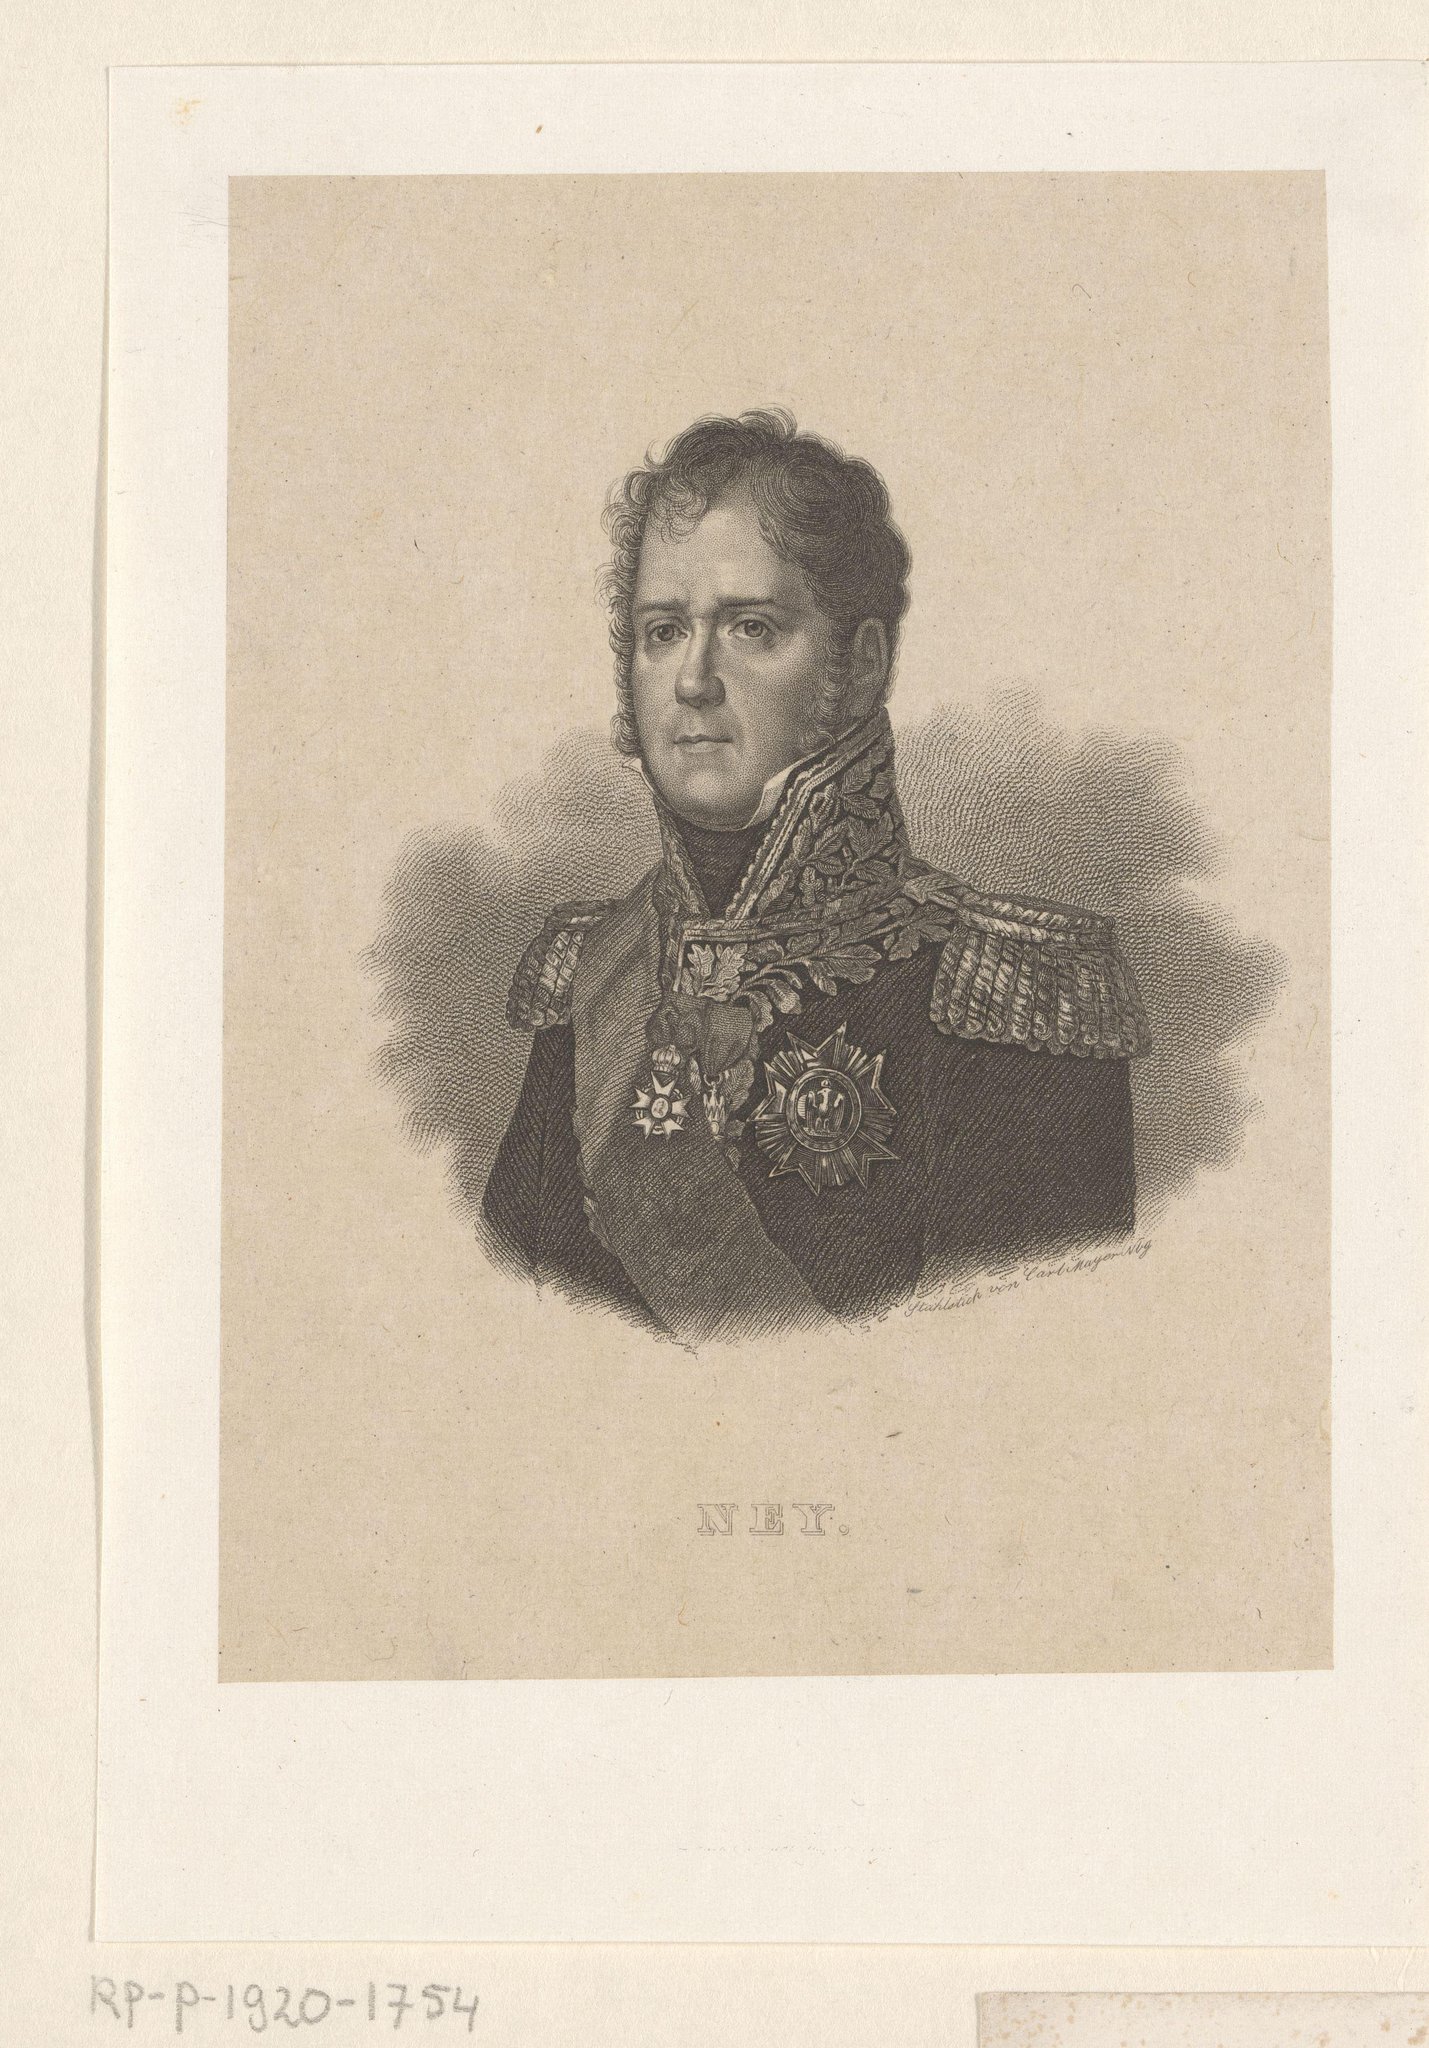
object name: print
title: Portret van Michel Ney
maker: carl mayer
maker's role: print maker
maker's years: 1798-1868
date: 1808-1868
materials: paper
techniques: engraving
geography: nuremberg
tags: paris, historical persons, officer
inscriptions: collector's mark: Lugt 2228